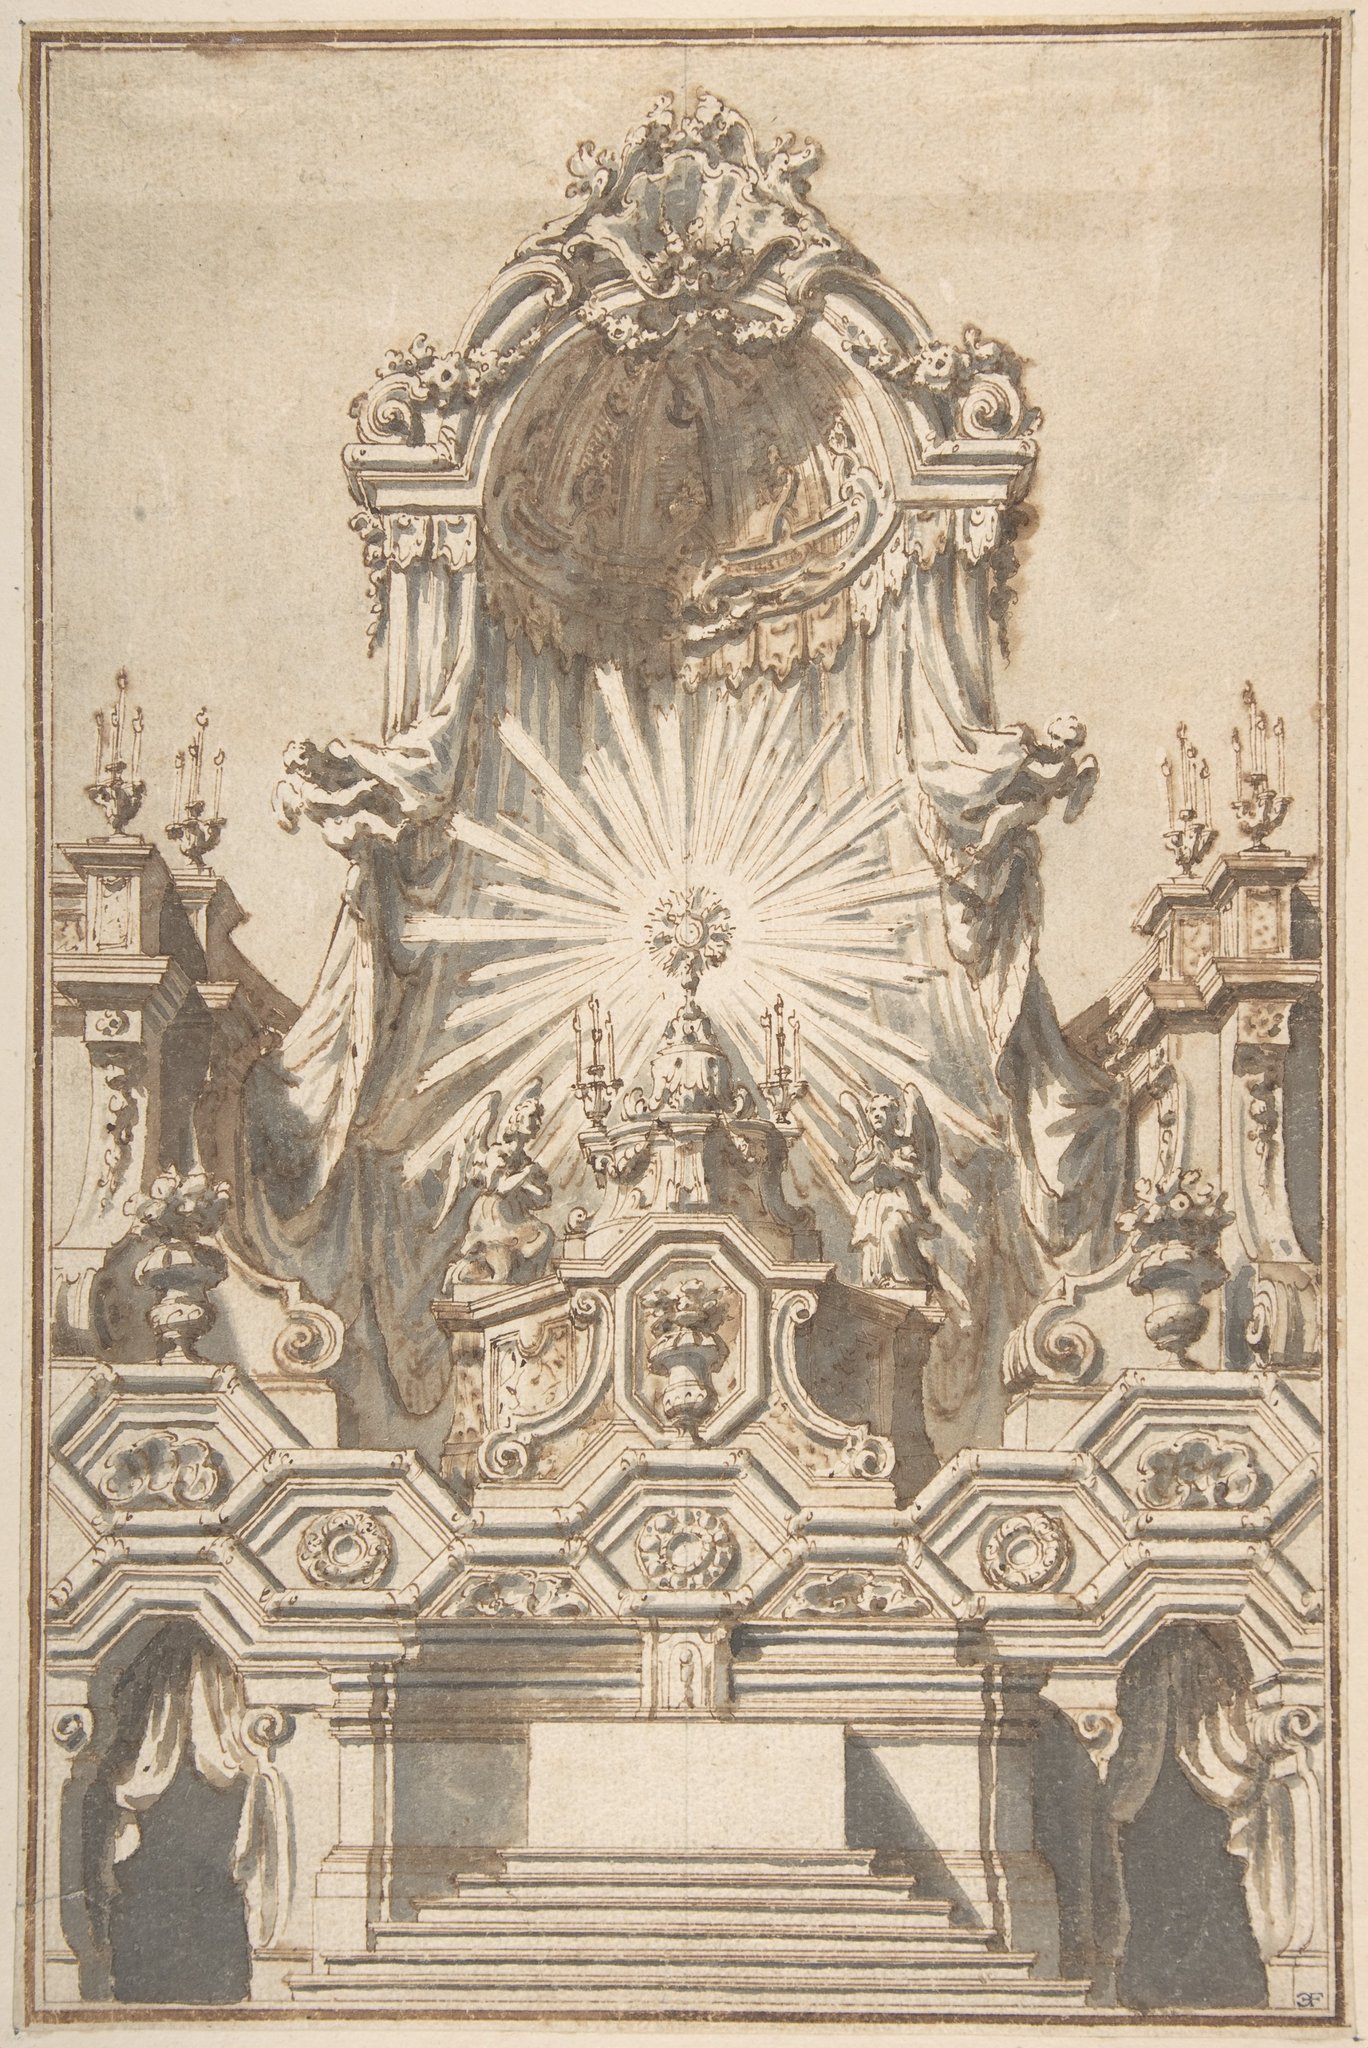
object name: drawing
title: Framed Design for an Altar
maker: giuseppe galli bibiena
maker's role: artist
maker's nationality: italian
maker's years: 1696-1756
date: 1710-1720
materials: ink, paper, drawing material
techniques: brush, pen, wash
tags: altars